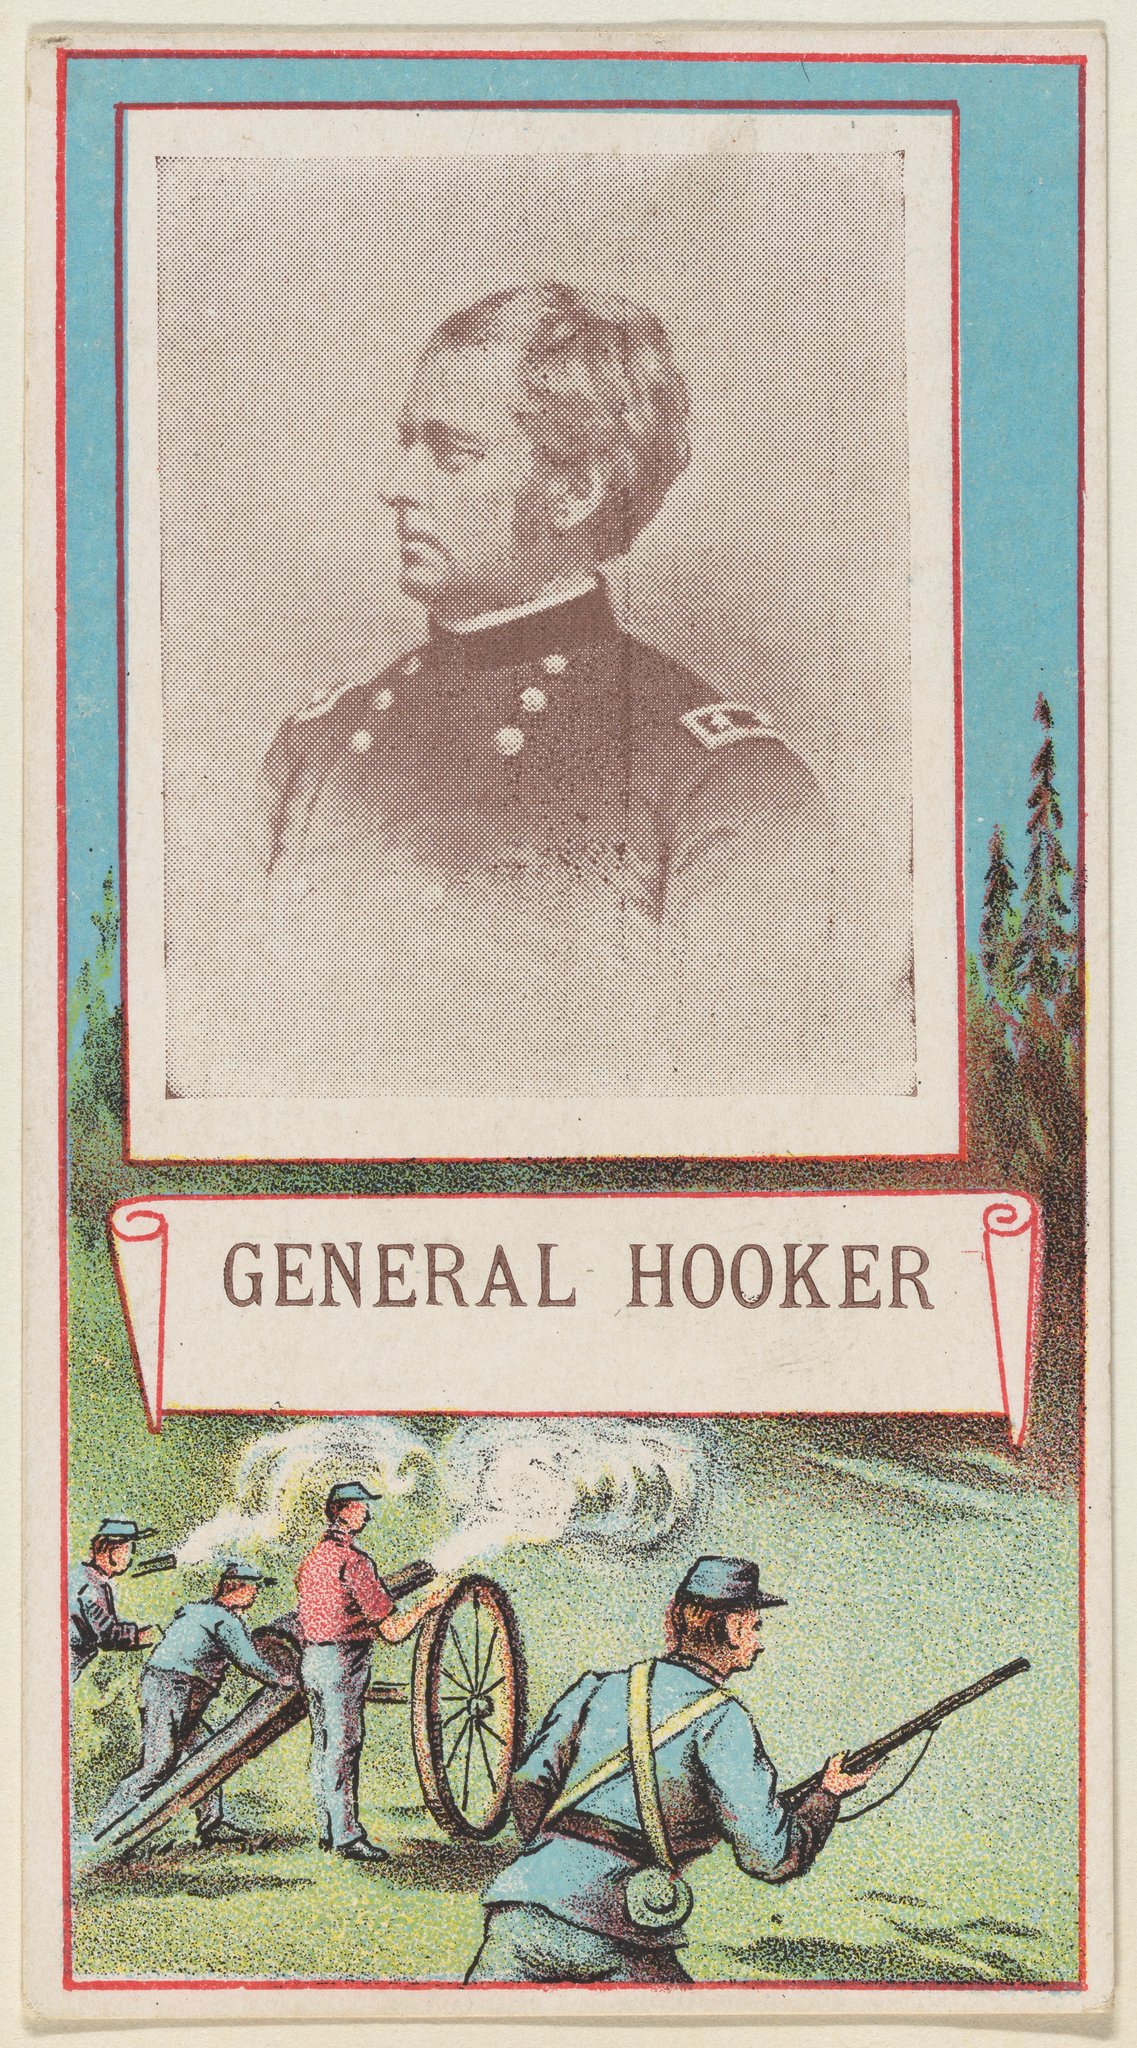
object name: print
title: General Hooker, from the "Generals" series (T64), issued by D.H. McAlpin & Co. Tobacco Company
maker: d.h. mcalpin & co. tobacco company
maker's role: publisher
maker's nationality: american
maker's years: 1857-1901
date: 1901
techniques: color lithograph